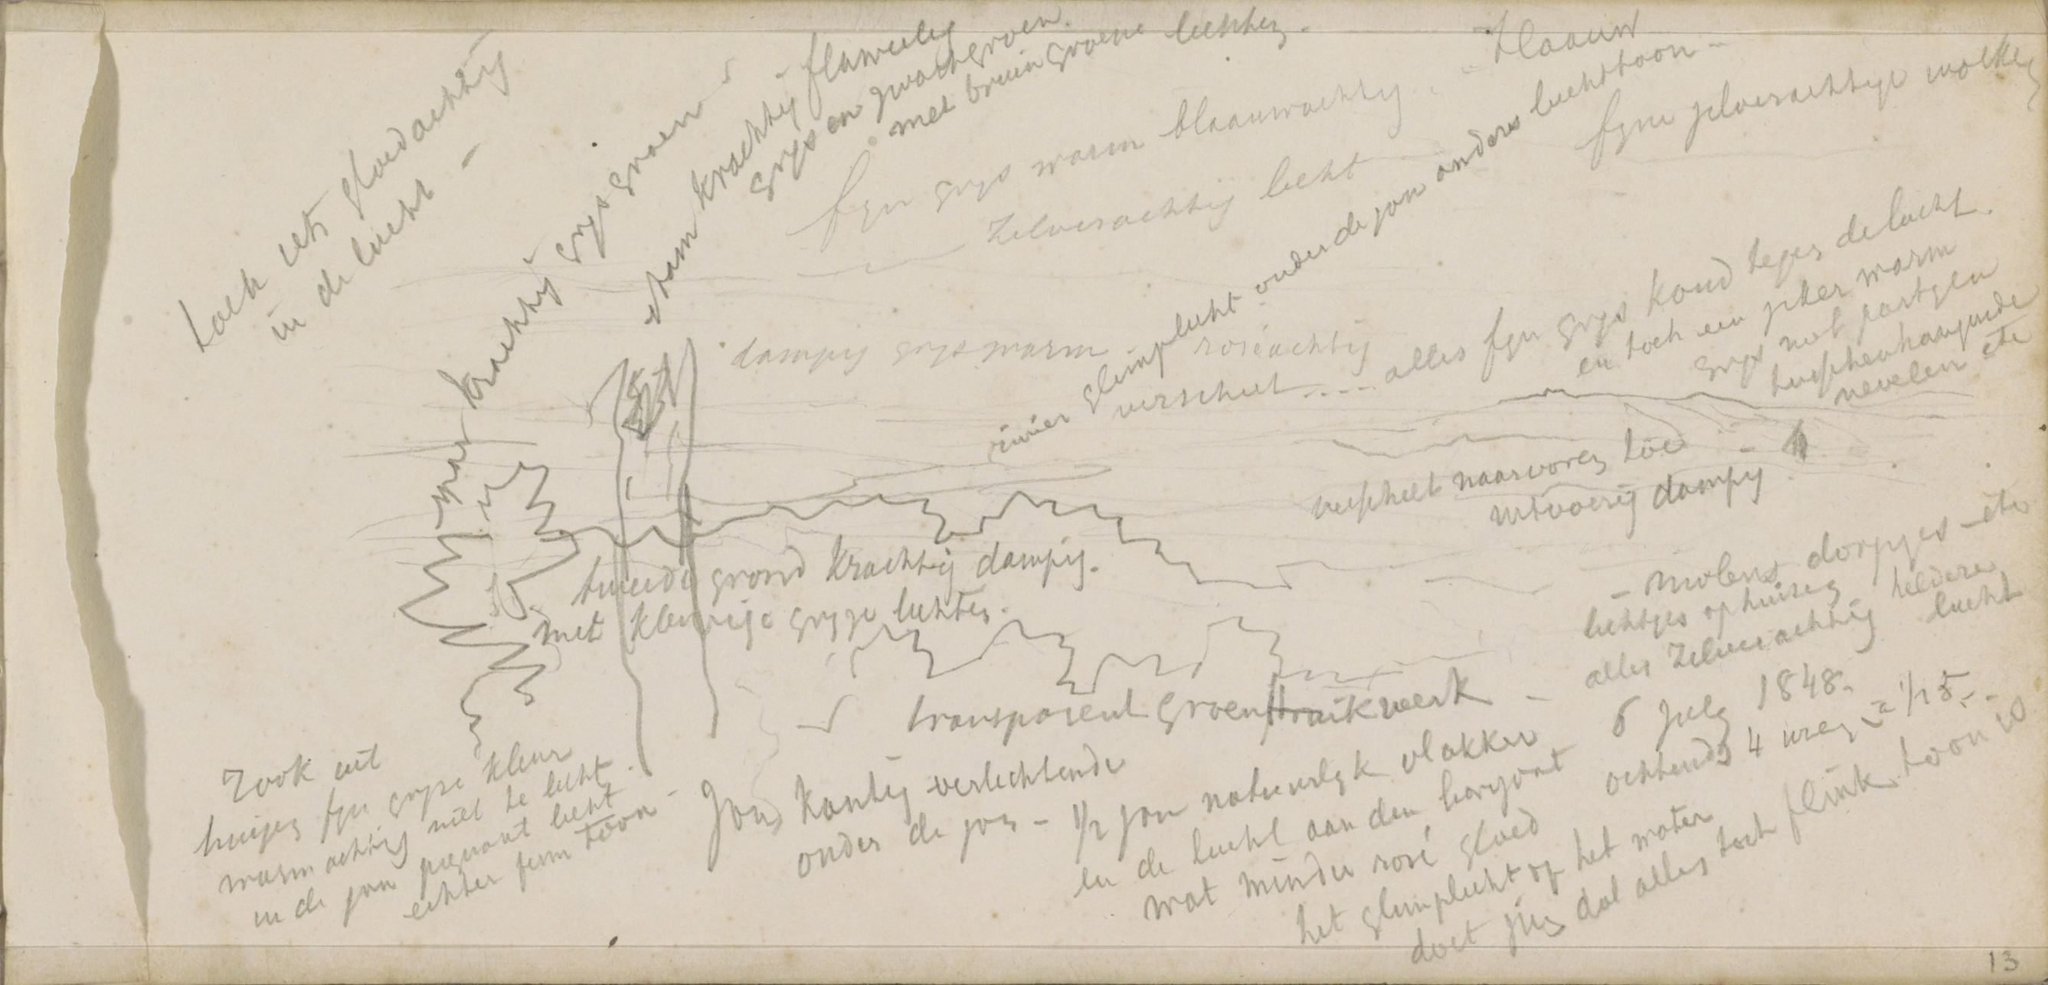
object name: sketchbook leaf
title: Dennenbos aan een rivier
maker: johannes tavenraat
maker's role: draughtsman, painter, print maker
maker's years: 1809-1881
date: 1848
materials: paper, pencil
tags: river, forest, wood, trees: pine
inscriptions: kleurnotitie, handgeschreven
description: Blad 13 recto uit een schetsboek met 63 bladen.